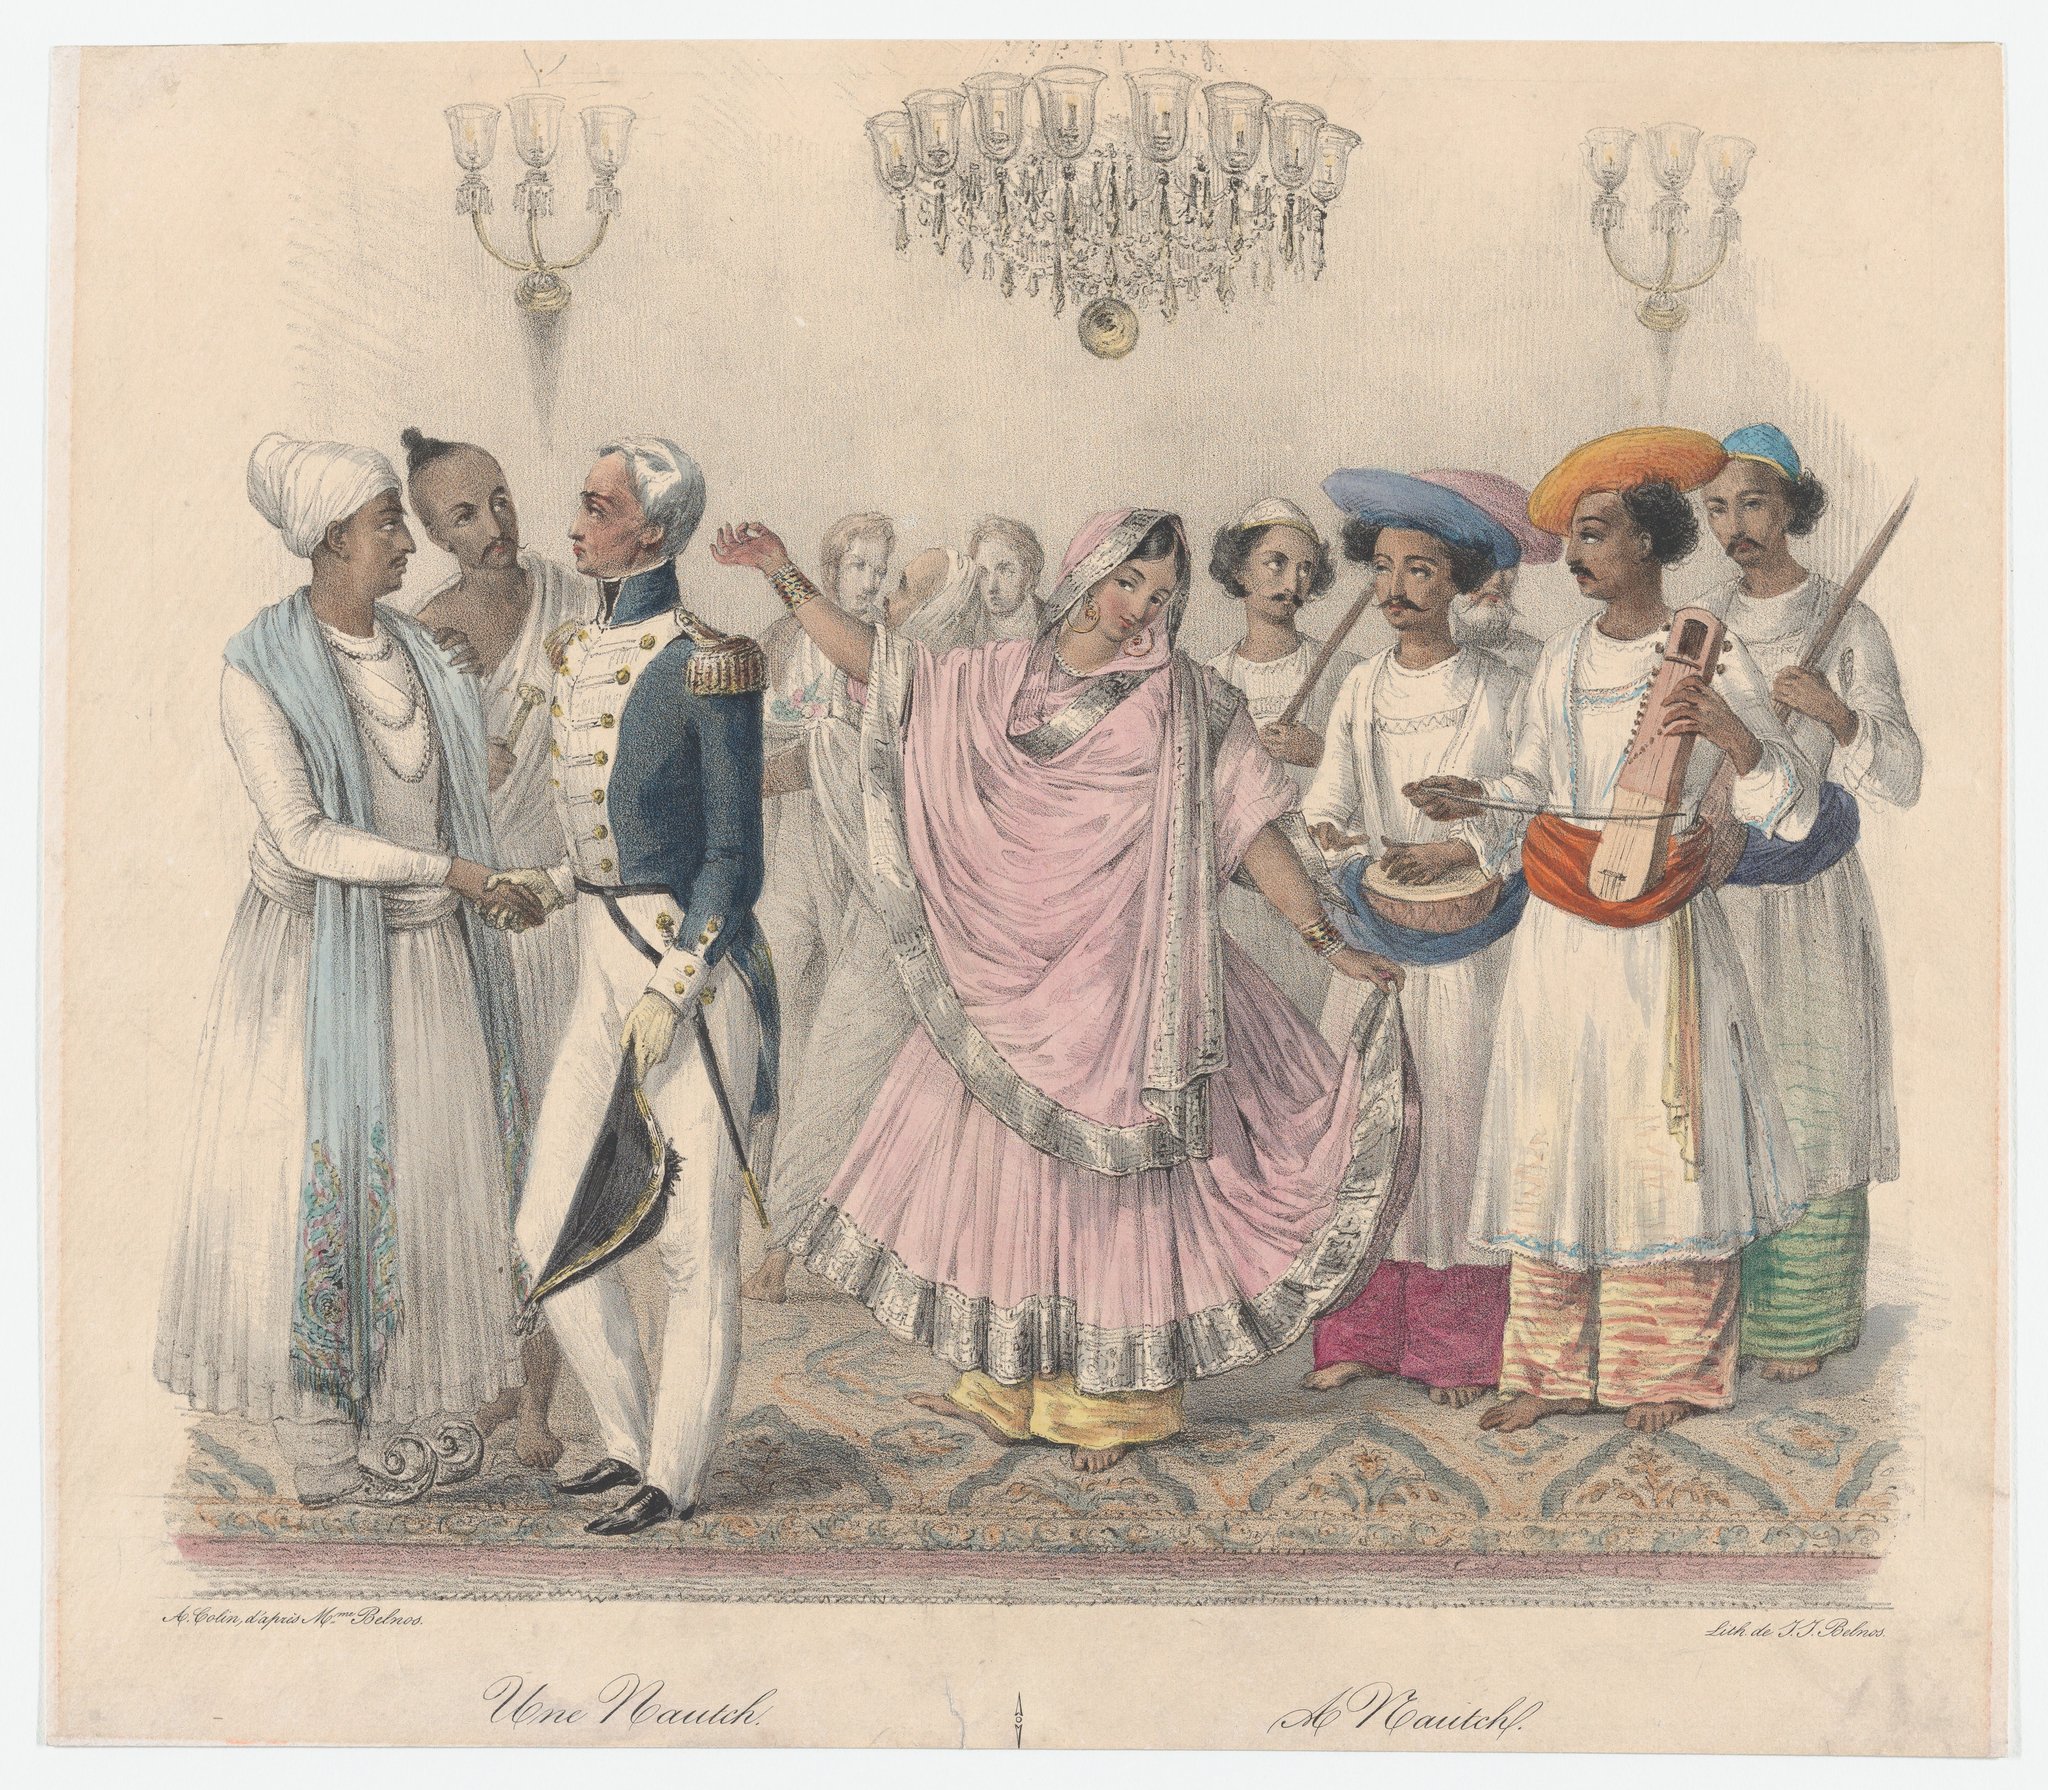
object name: print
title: Une Nautch; from Twenty four Plates Illustrative of Hindoo and European Manners in Bengal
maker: alexandre-marie colin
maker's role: artist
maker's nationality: french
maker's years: 1798-1875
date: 1832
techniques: hand coloring, lithograph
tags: musical instruments,men,women,dancing,musicians